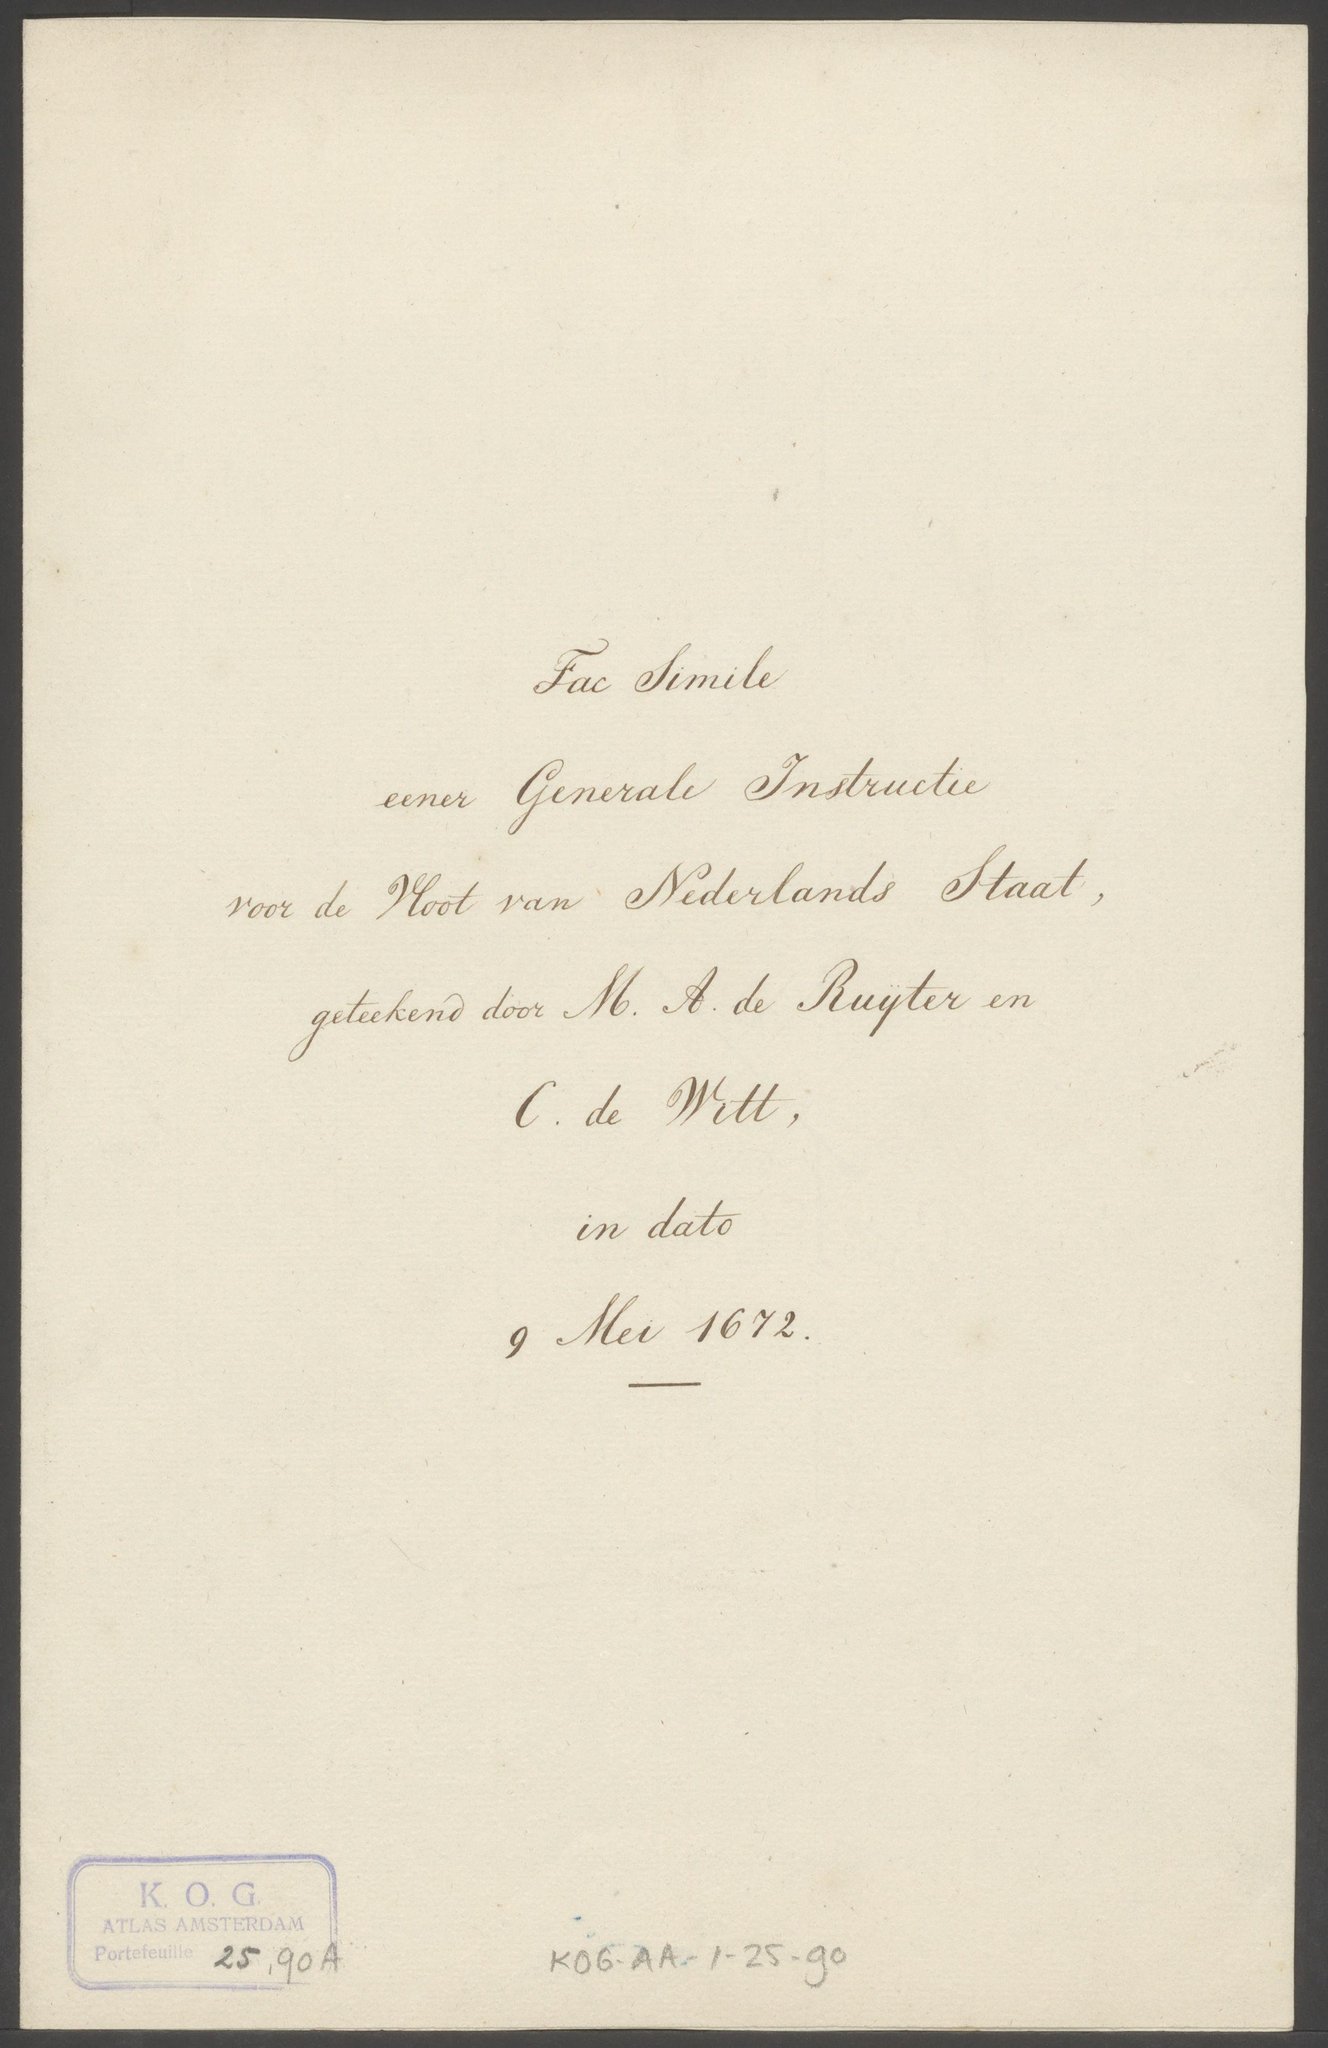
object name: letter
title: Fac Simile eener Generale Instructie voor de Vloot van Nederlands Staat, geteekend door M.A. de Ruyter en C. de Witt, in dato 9 Mei 1672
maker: Anonymous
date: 1800-1899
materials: ink, paper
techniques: pen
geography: northern netherlands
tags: flushing, michiel adriaenszoon de ruyter, dordrecht, the hague, cornelis de witt, command, navy, military instruction, preparation for battle, battle of solebay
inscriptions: collector's mark: ‘25.90A’ Lugt 1641b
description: Transcriptie van een facsimile van instructies gericht aan de vloot van de Republiek der Zeven Verenigde Nederlanden, inclusief toelichting. Bestaande uit twee pagina's. Onderwerpsrubriek binnen de Atlas Amsterdam: Krijgswezen I: De Admiraliteit van Amsterdam, B. Vlootvoogden en schepelingen; Herinneringen daaraan.